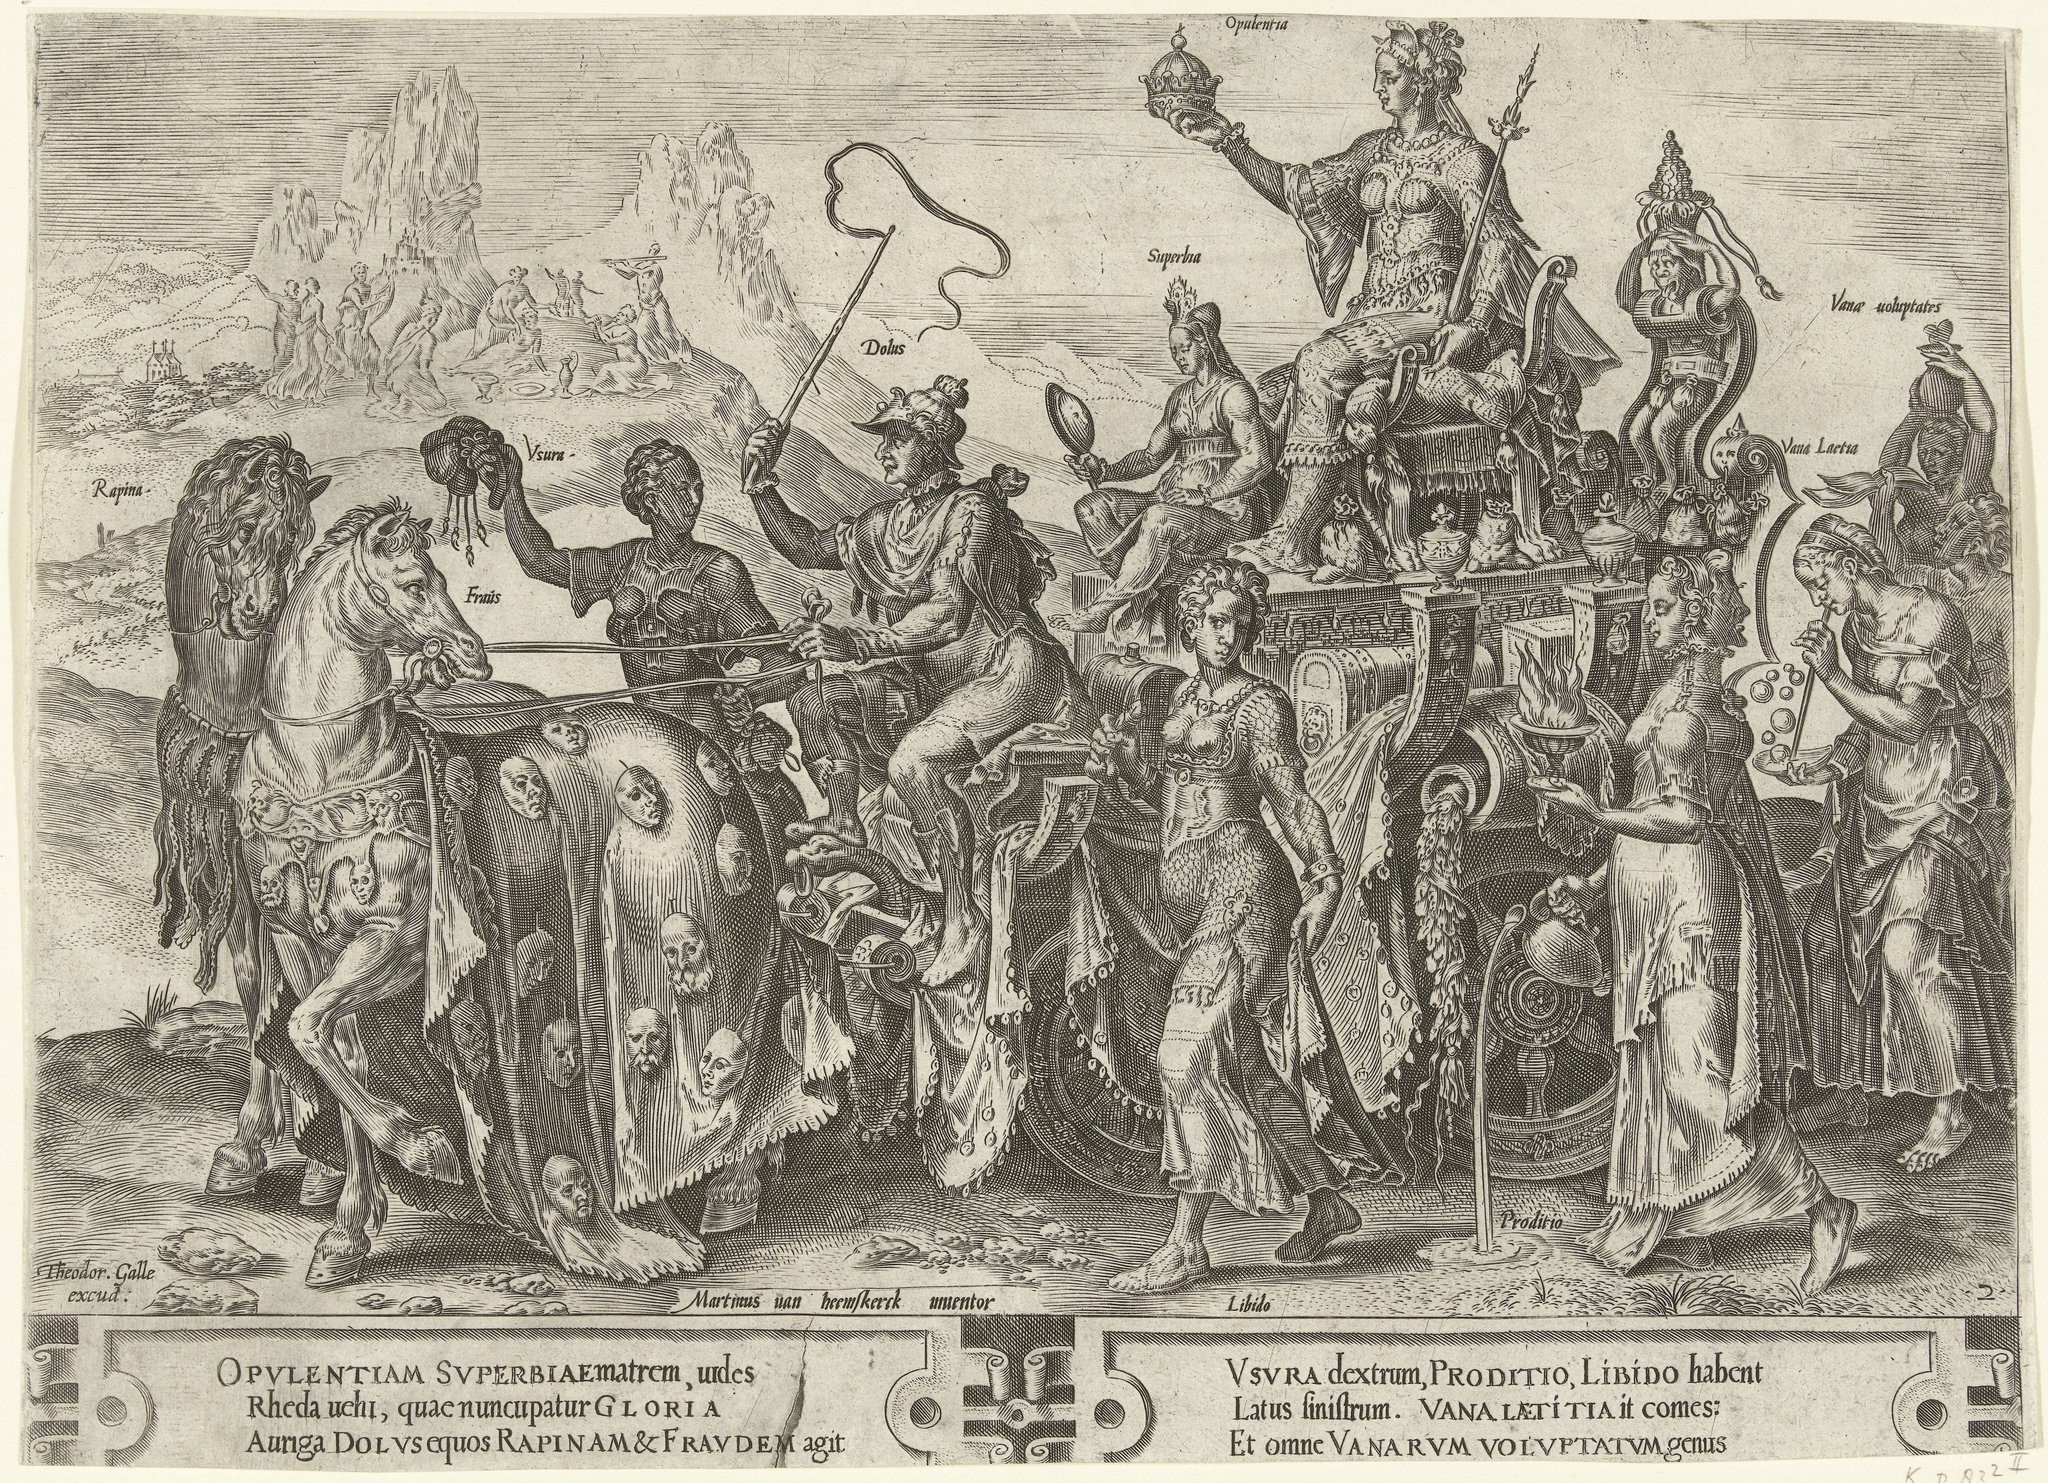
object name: print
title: Circulus Vicissitudinis Rerum Humanarum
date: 1564-1633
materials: paper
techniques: engraving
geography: antwerp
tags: vicissitudes of life (+ allegorical scene, i.e. two or more personifications involved in an action), chariot, triumphal car, wealth, opulence; 'opulenza', 'richezza' (ripa)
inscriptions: collector's mark: Lugt 2760, collector's mark: Lugt 2228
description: Op een triomfwagen zit de personificatie van de rijkdom (Opulentia) met kroon en scepter, zakken met geld onder haar troon. De wagen wordt begeleidt door personificaties van Woeker (Usura), Lust (Libido), Verraad (Proditio) en List (Dolus) die ervoor zorgen dat rijkdom tot stand komt. Prent uit een serie van negen prenten met triomfwagens uit de Antwerpse Besnijdenis-ommegang van 1561. De personificaties op de wagens verbeelden samen de kringloop van het menselijk handelen.